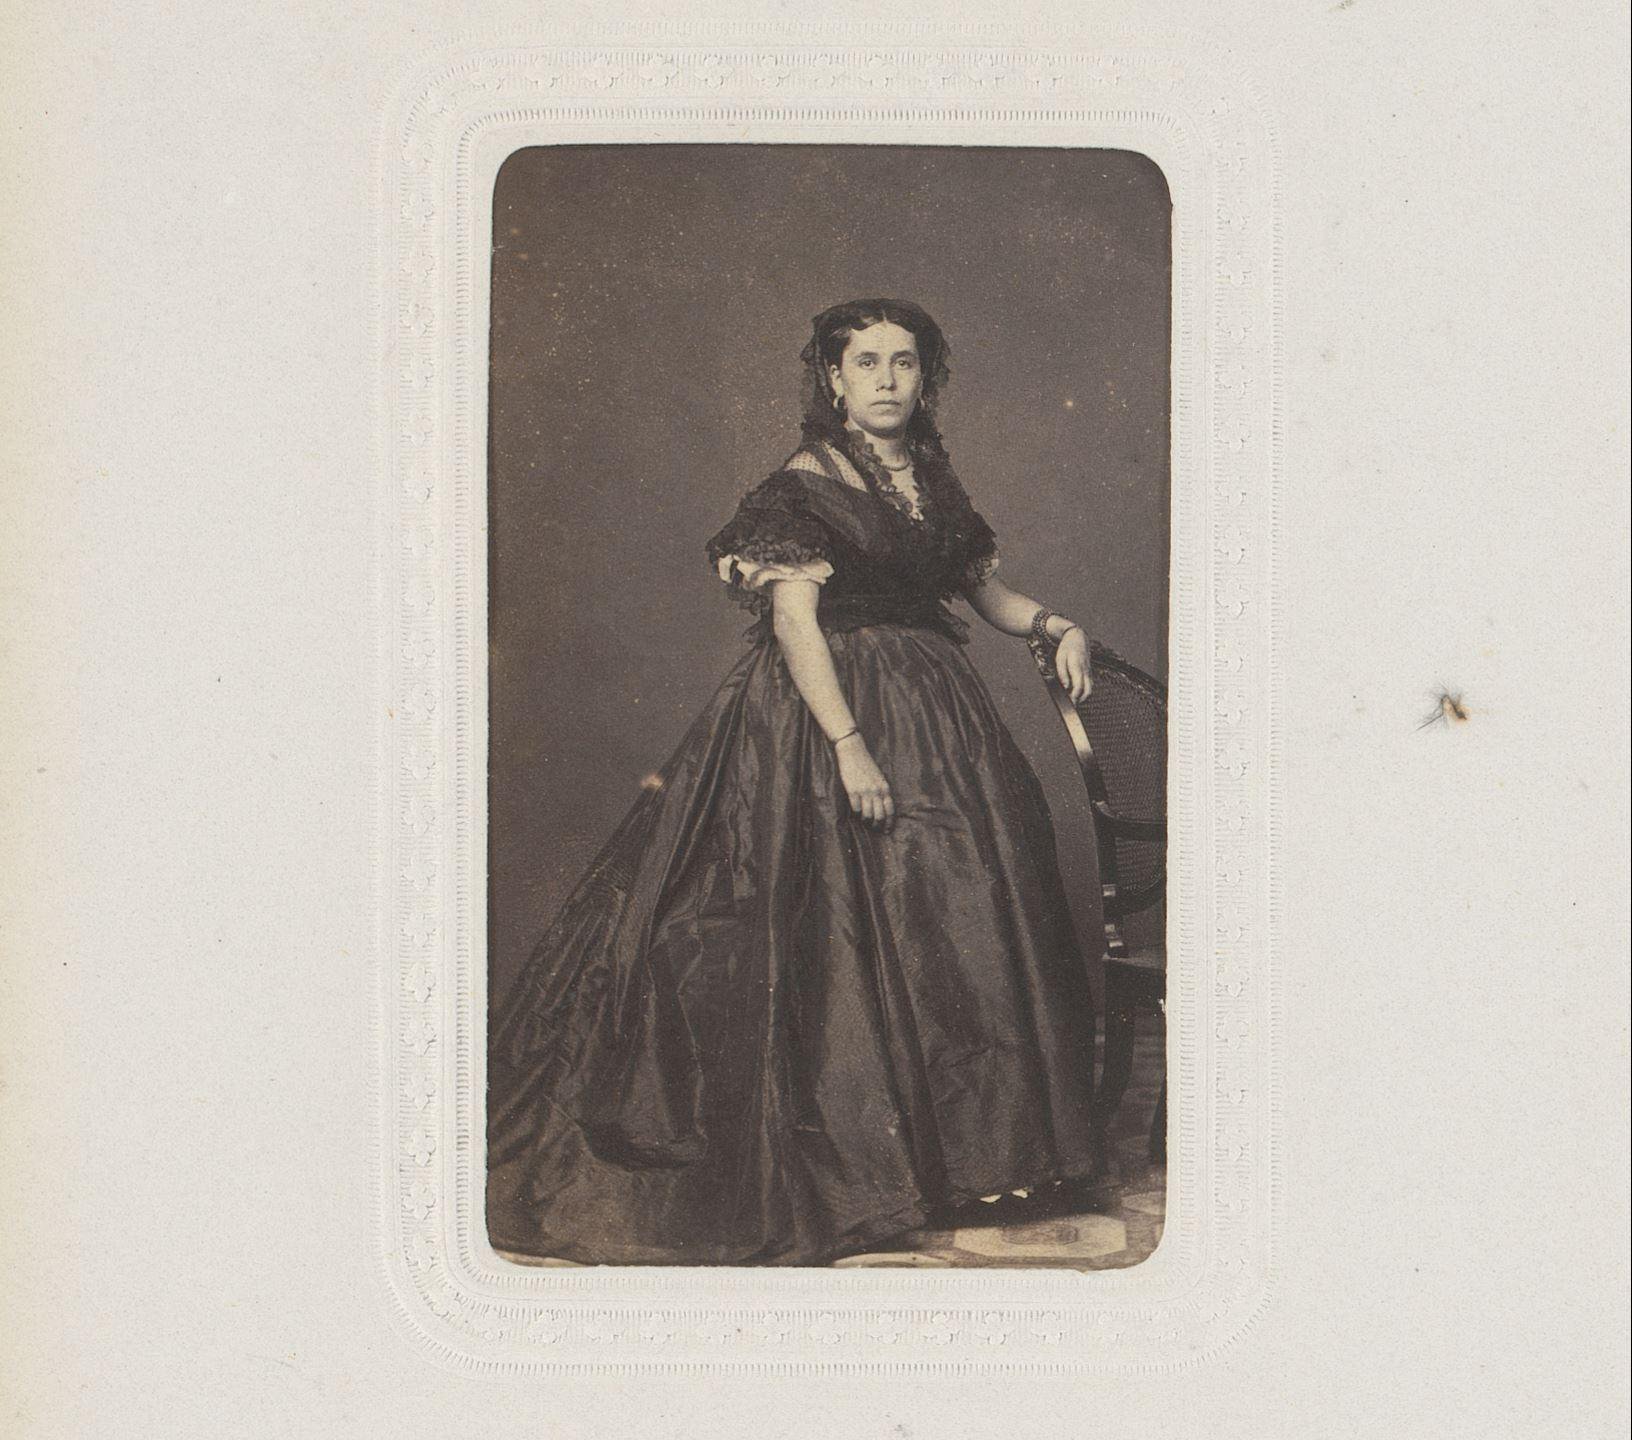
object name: album leaf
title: Portret van een vrouw, staand bij een stoel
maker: Anonymous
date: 1860-1890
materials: cardboard, photographic support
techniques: albumen print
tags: historical persons - bb - woman, standing figure - aa - female human figure